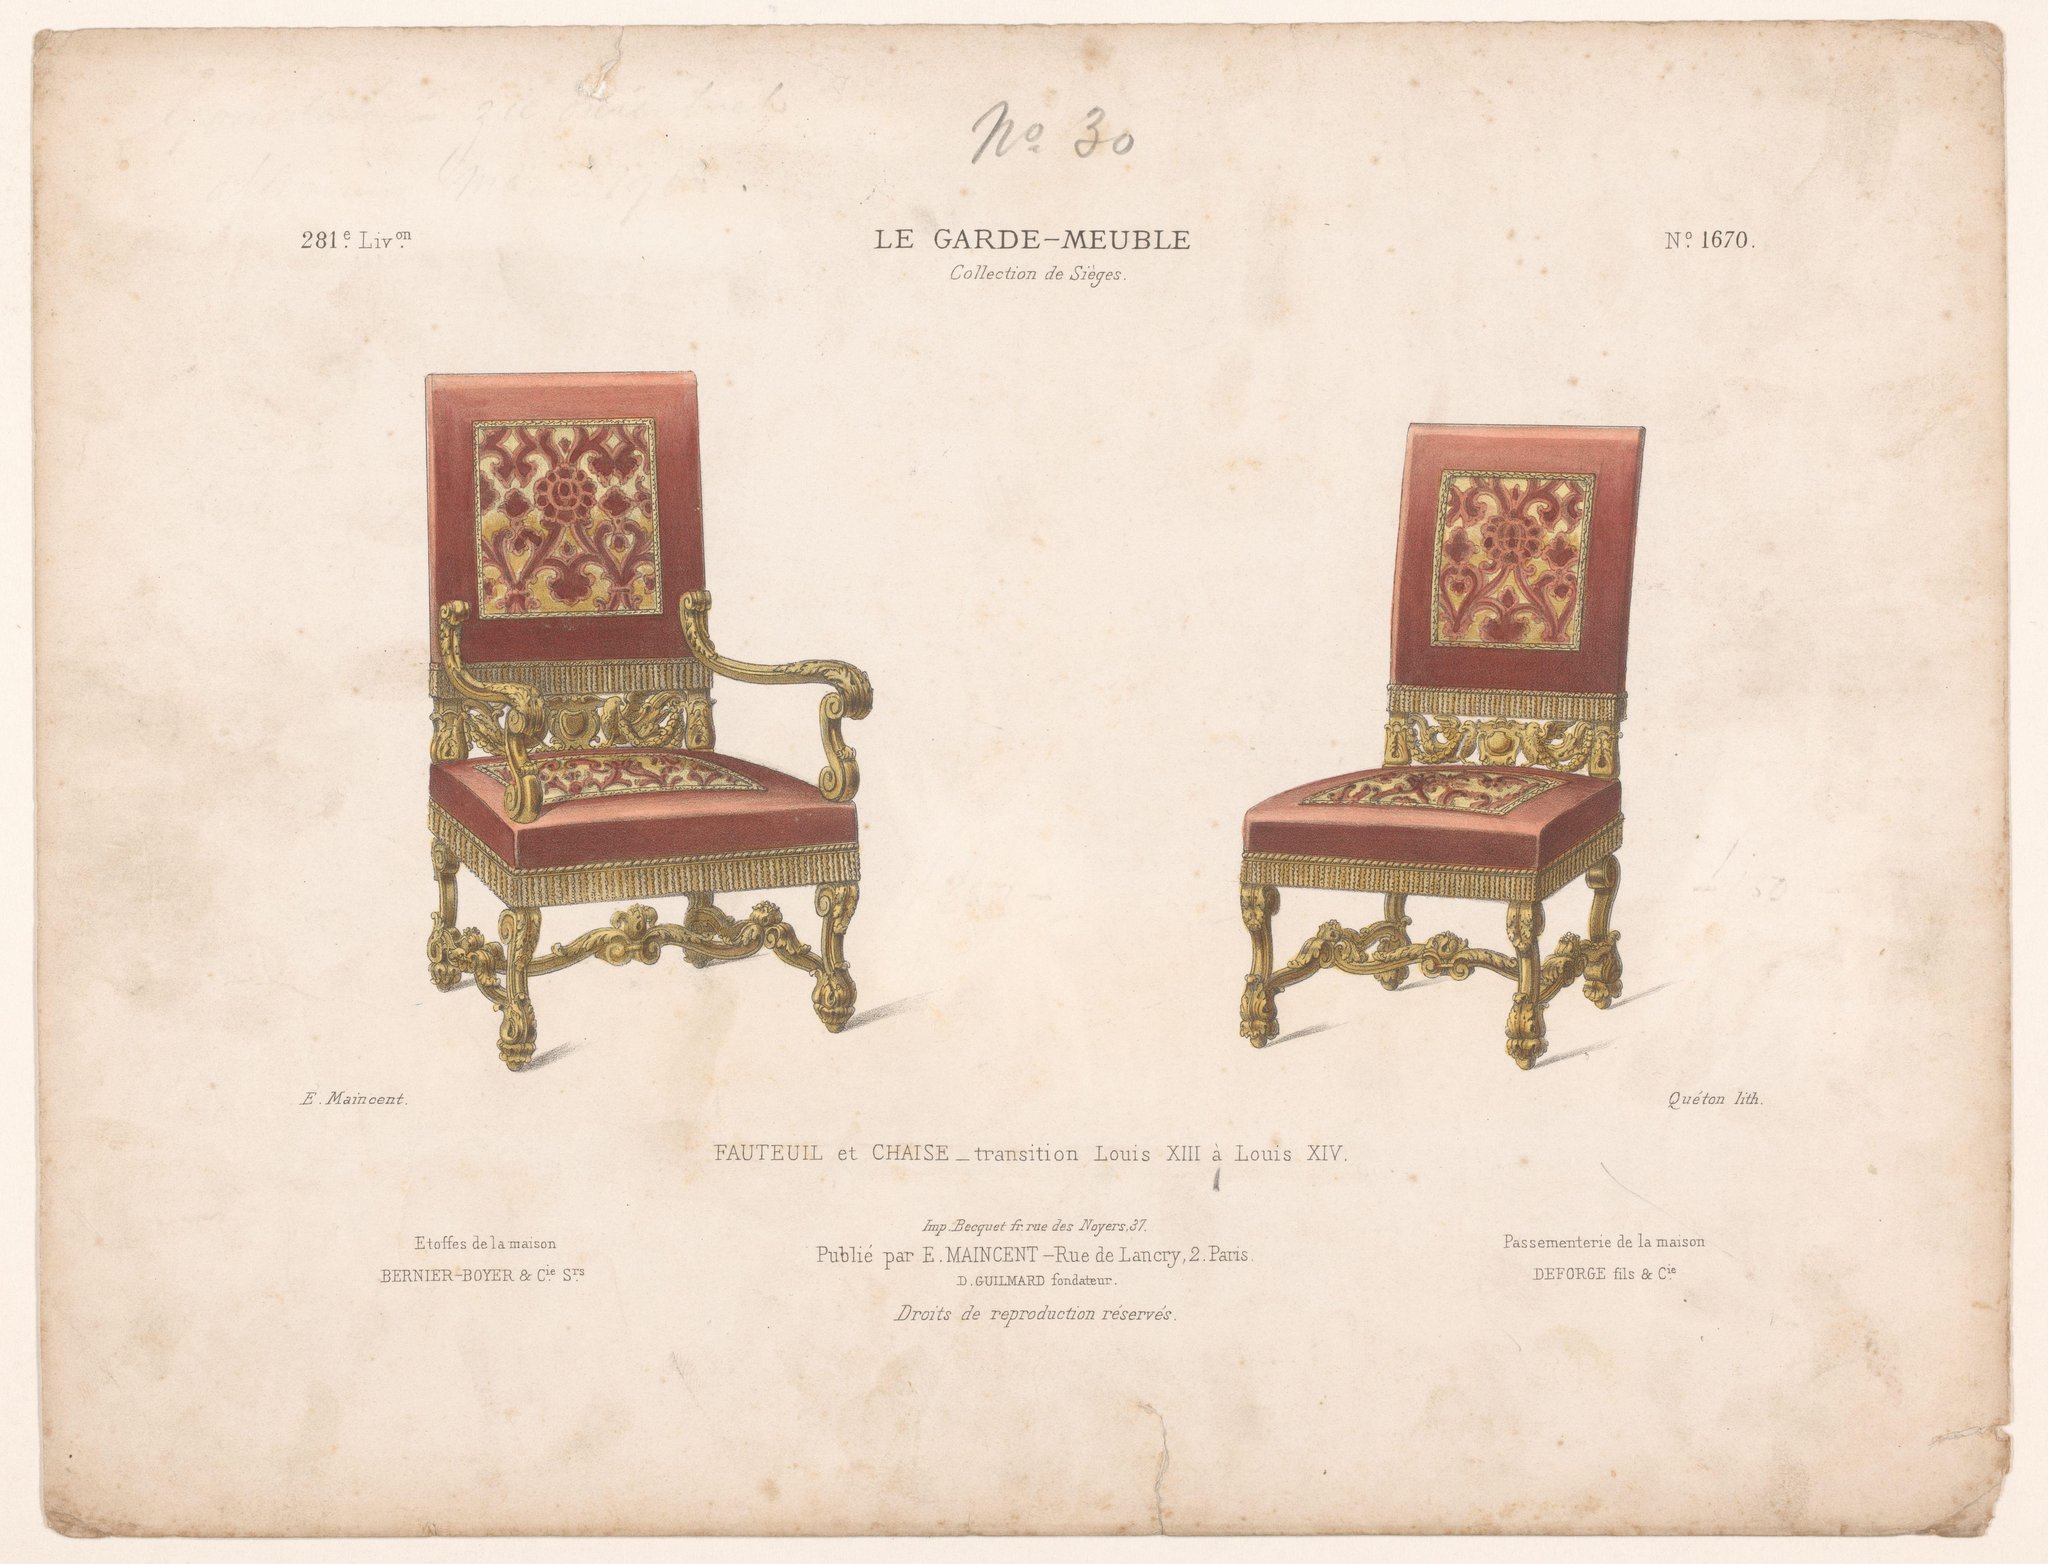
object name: print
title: Le garde-meuble / Collection de Sièges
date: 1885-1895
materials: paper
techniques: hand coloring, lithograph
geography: paris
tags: seating furniture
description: Ieder Livraison in de serie Le Garde-Meuble bevat negen platen: drie 'sièges' (zitmeubels), drie 'meubles' (diverse meubels zoals tafels en kasten) en drie 'tentures' (gordijnen en draperieën).